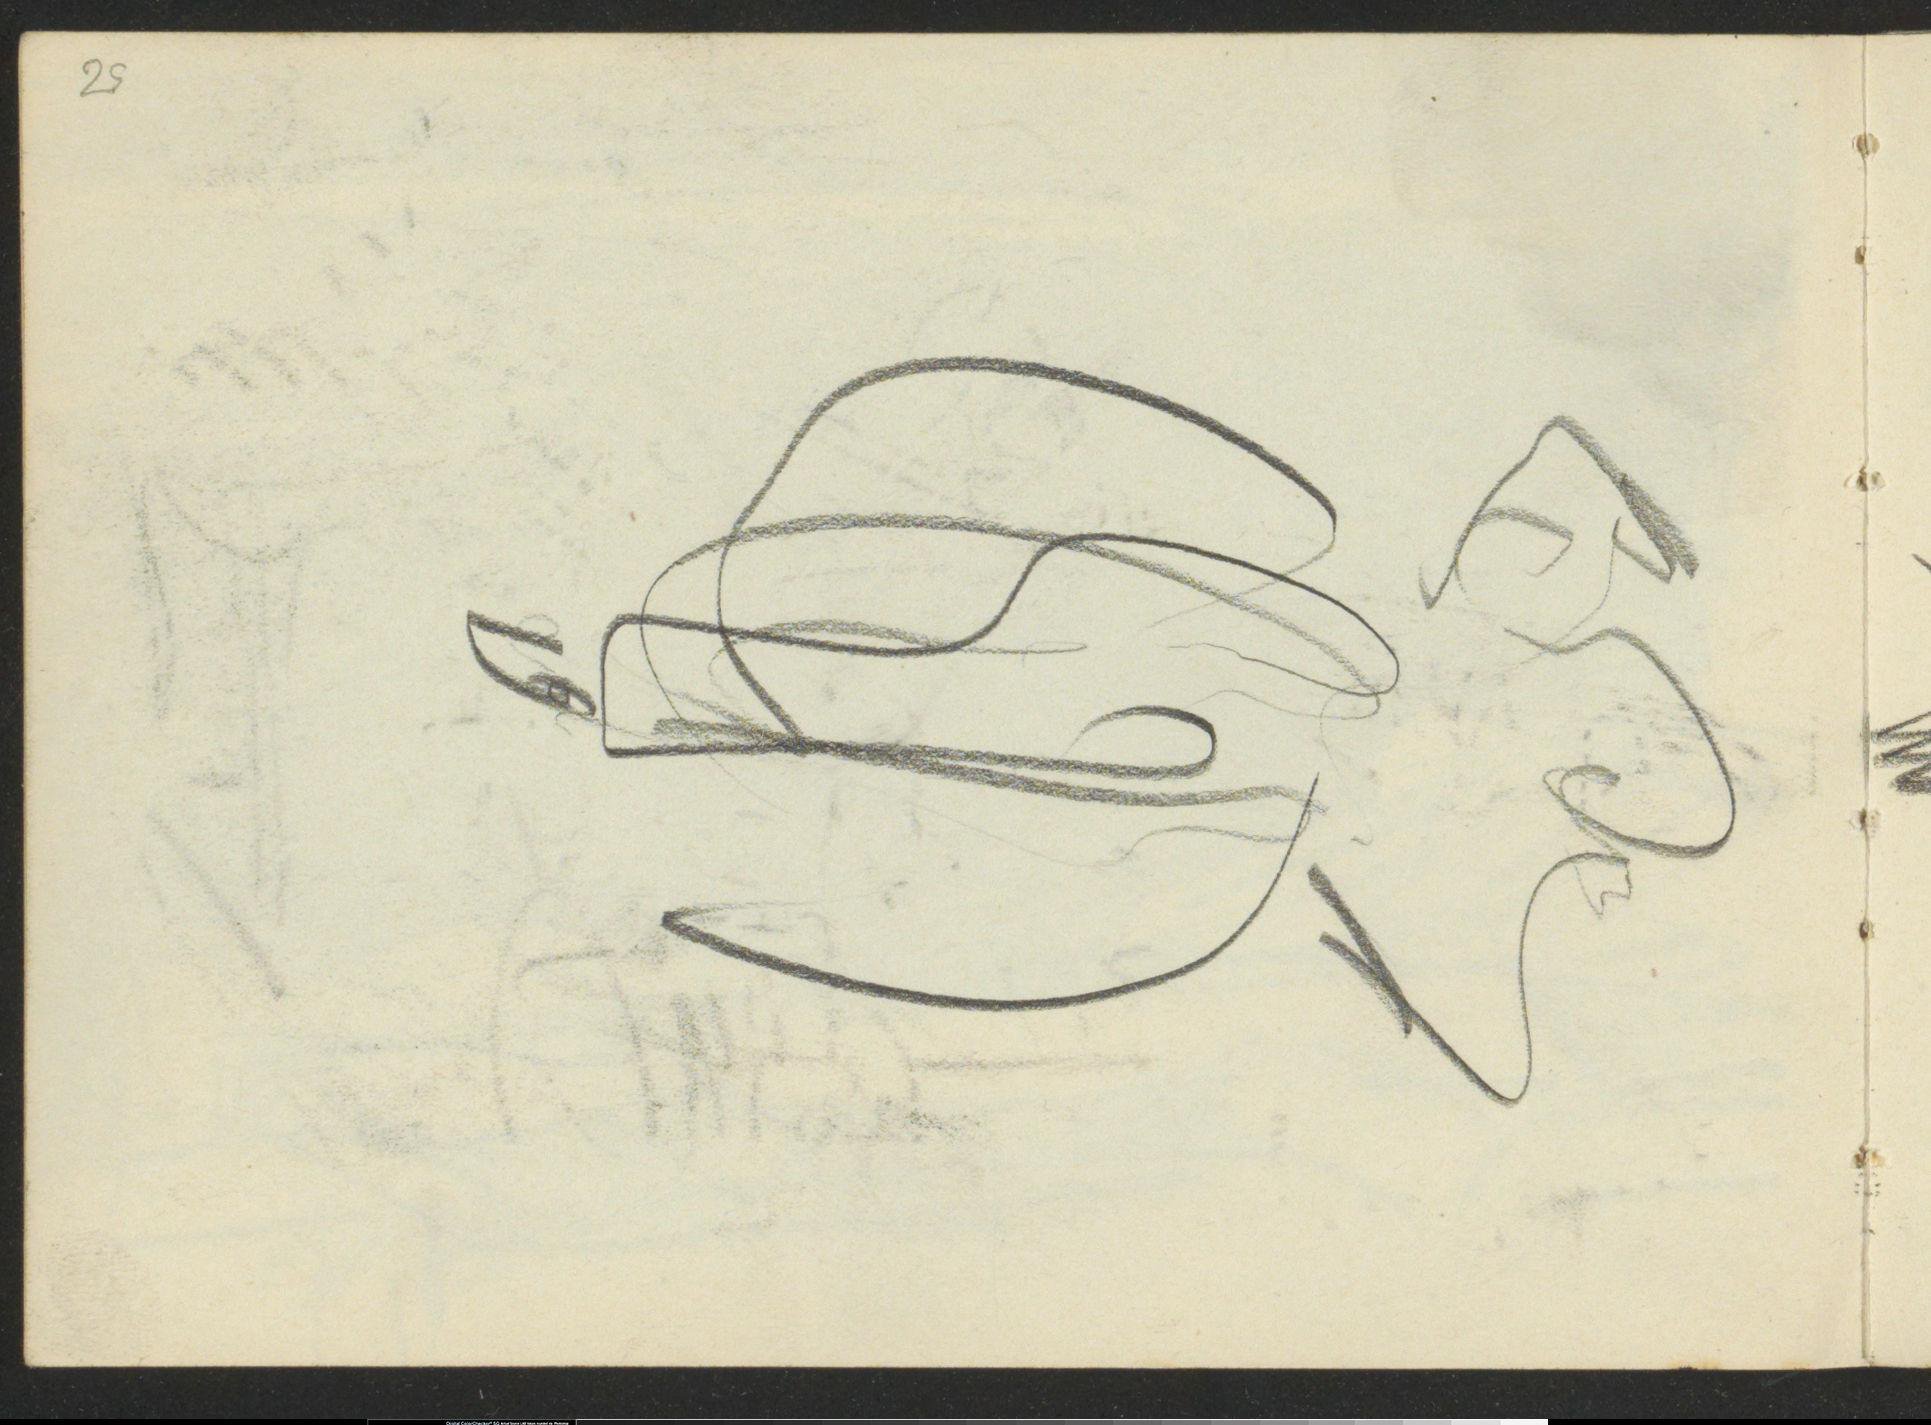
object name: sketchbook leaf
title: Studie, mogelijk van een staande vrouw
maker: isaac israels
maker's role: draughtsman, painter, print maker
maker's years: 1865-1934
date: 1875-1934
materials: paper, pencil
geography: the hague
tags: adult woman (+ standing)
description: Blad 3 verso uit schetsboek LVII met 29 bladen.